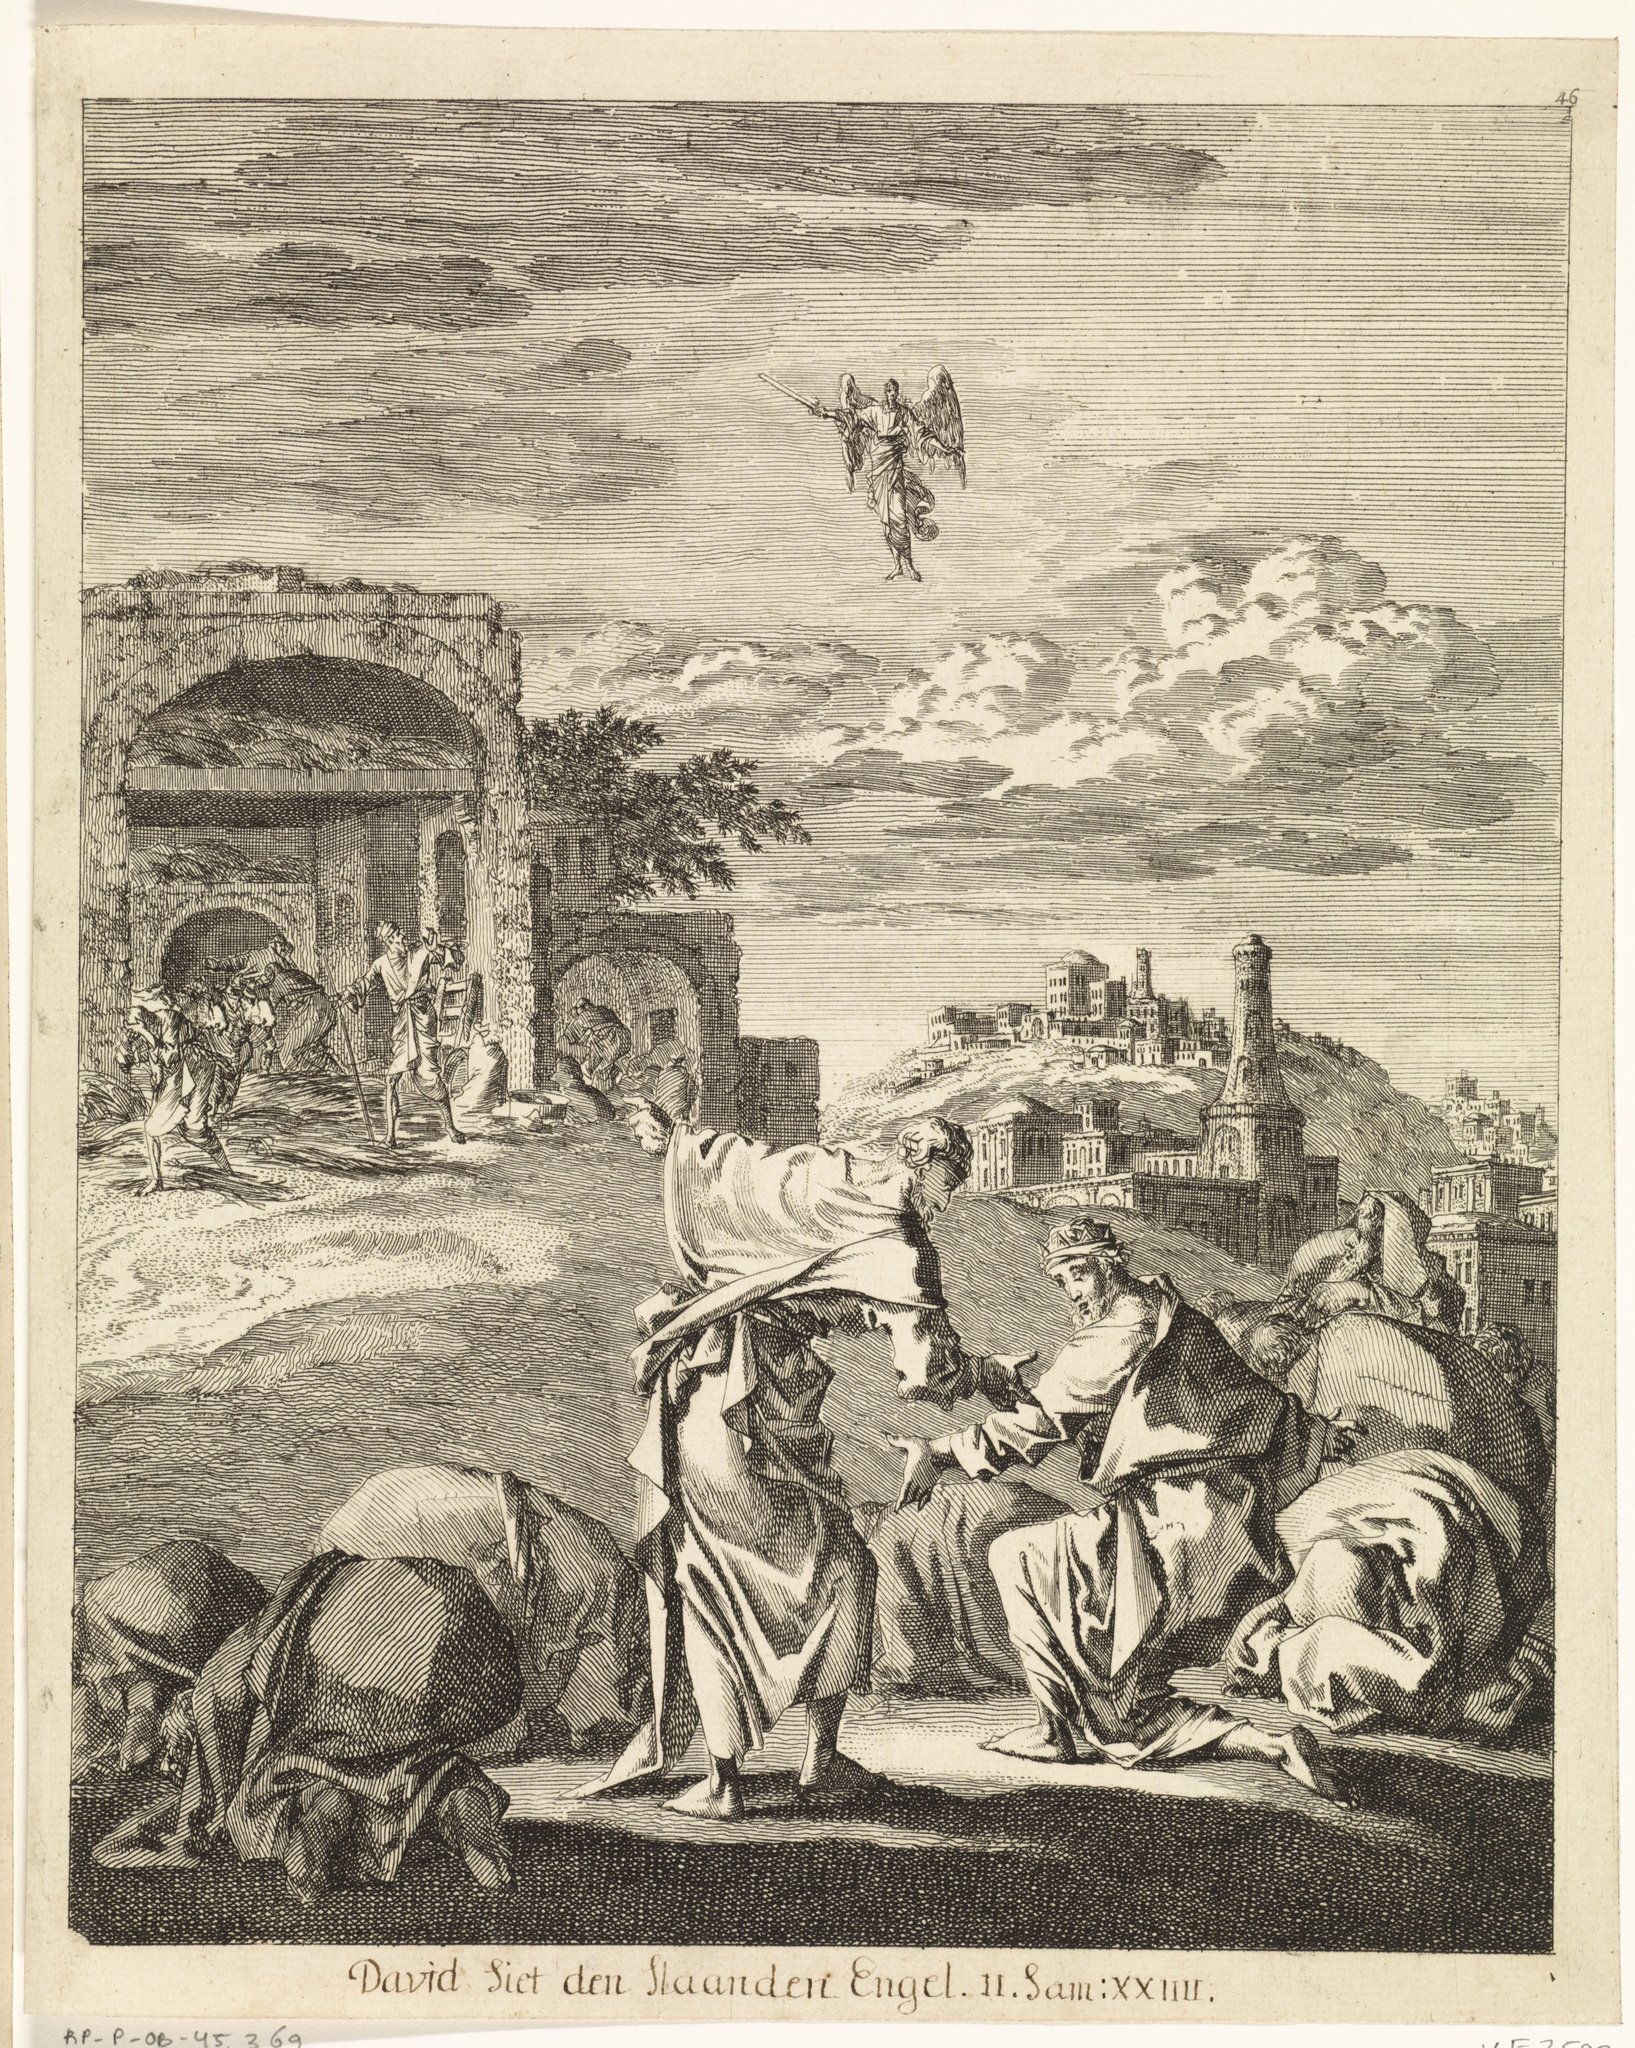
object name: print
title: Koning David ziet de engel des doods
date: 1708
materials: paper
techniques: etching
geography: amsterdam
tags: david sees the avenging angel in jerusalem; he prays to god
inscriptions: collector's mark: Lugt 2228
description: Proefdruk van een prent welke is opgenomen als illustratie in: Historiae Celebriores Veteris Testamenti. Christoph Weigel, 1708.